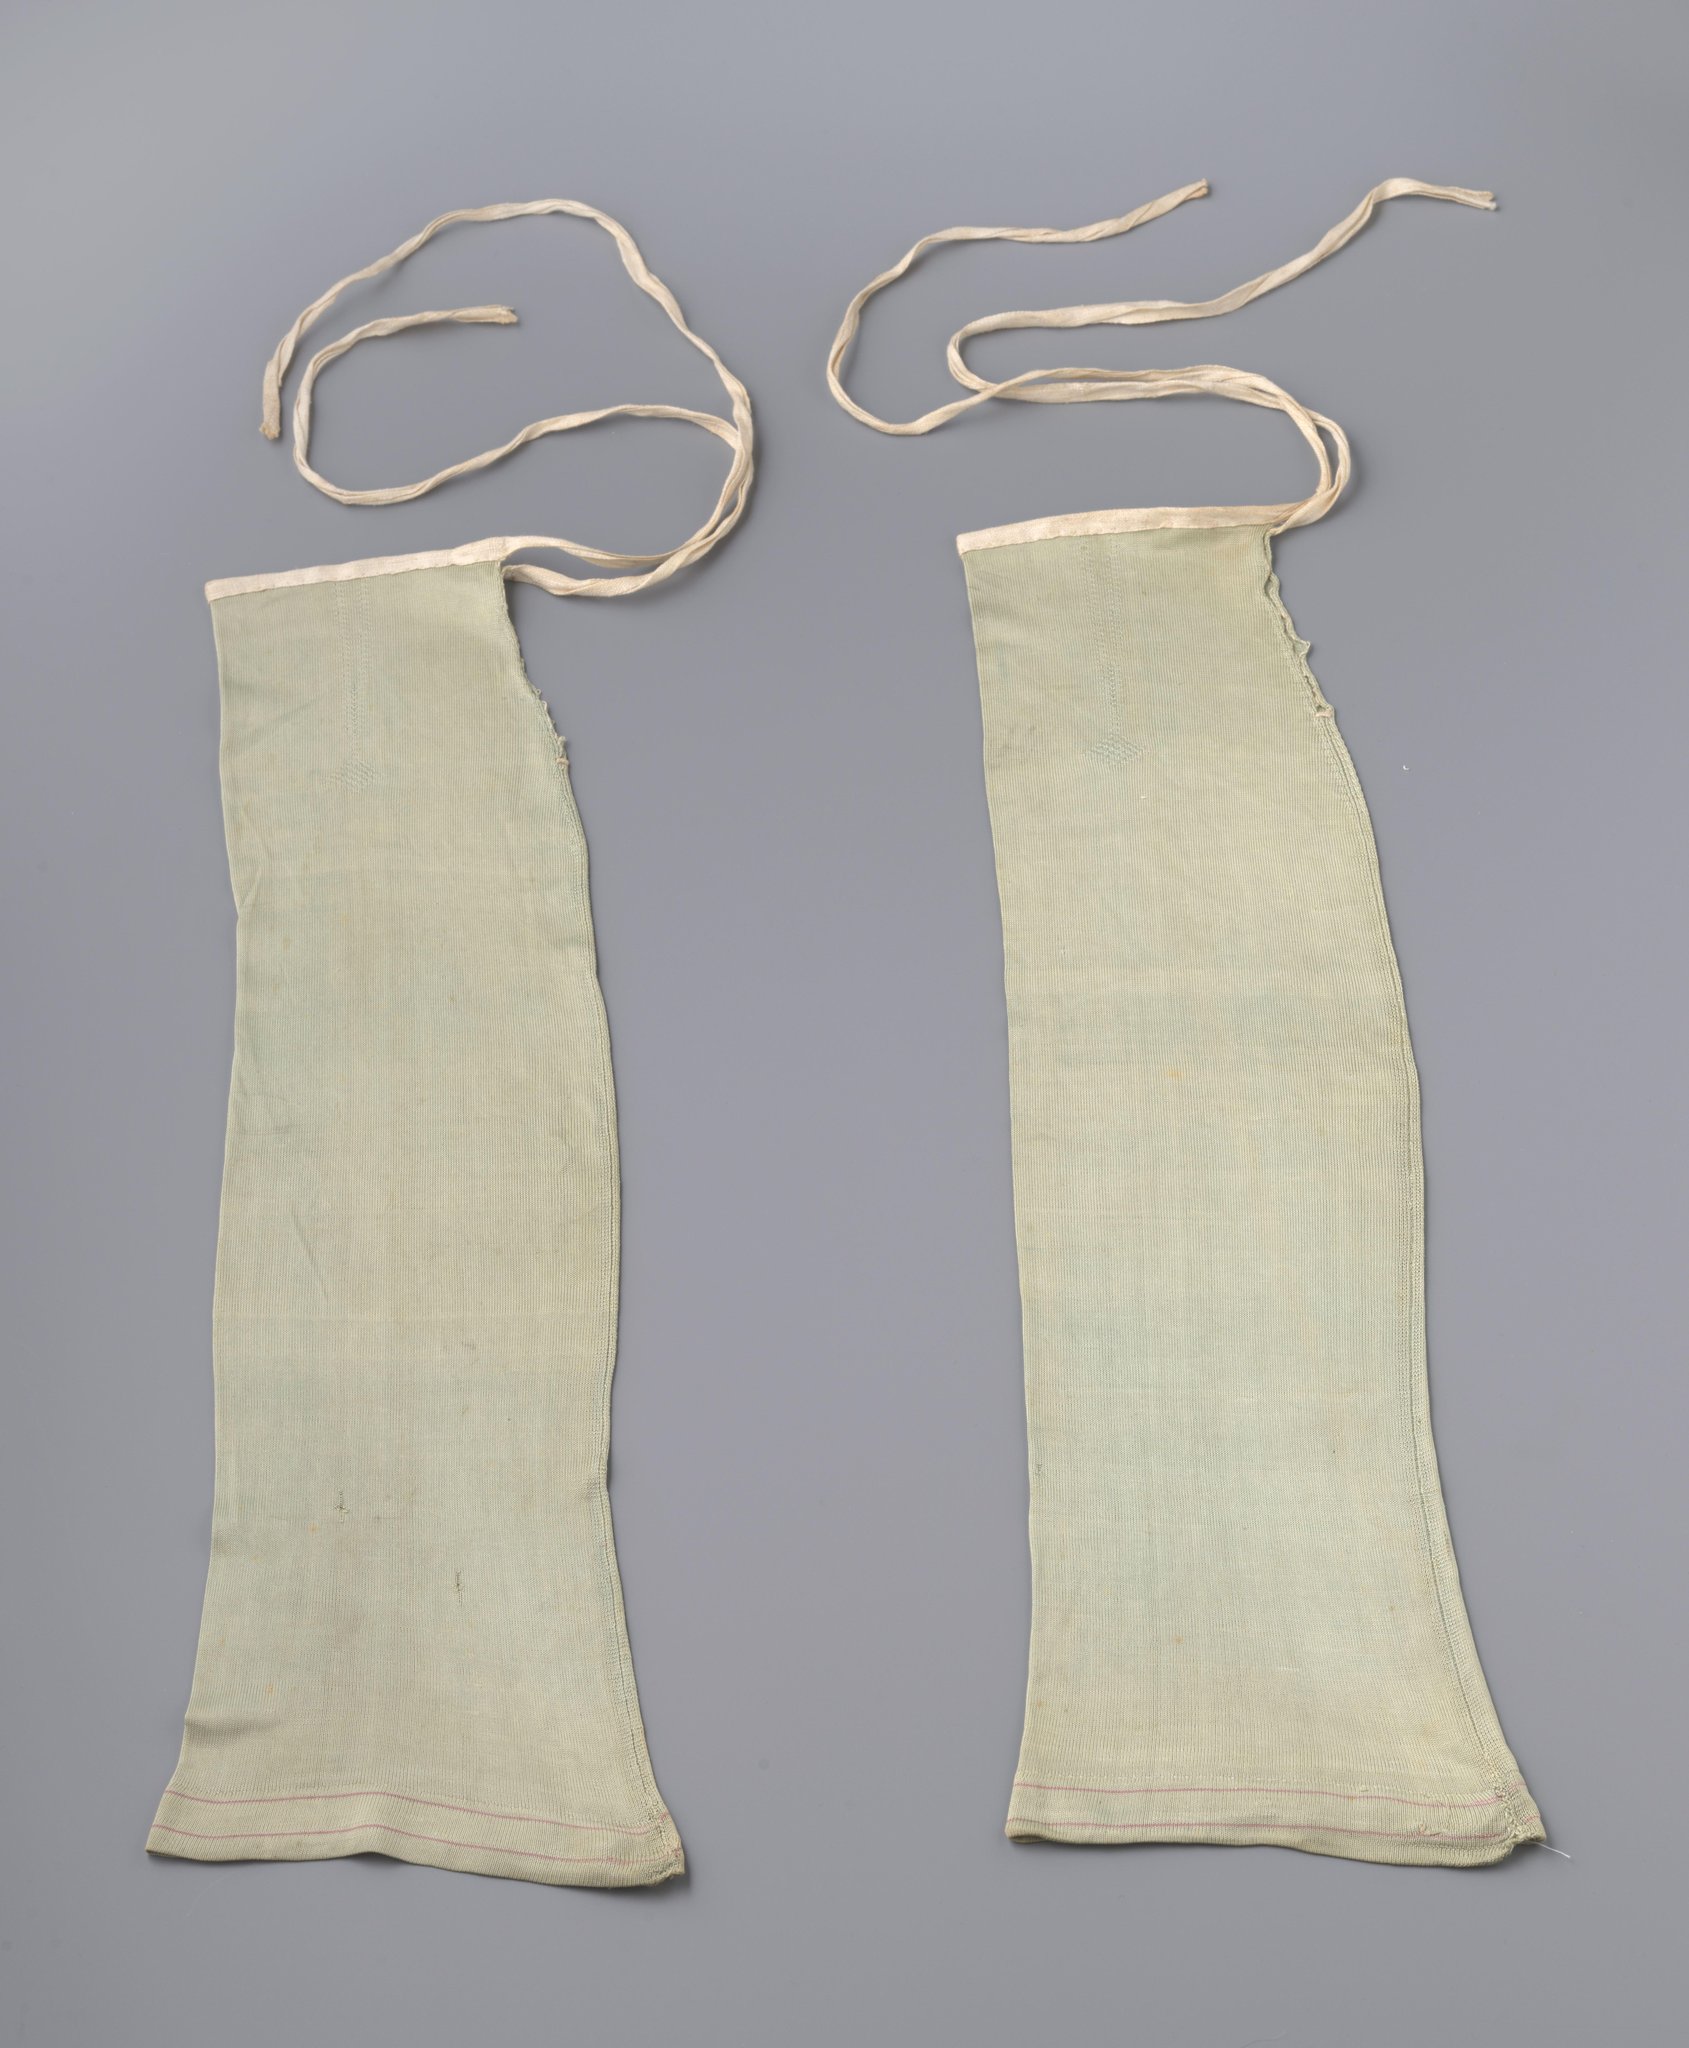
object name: spat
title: Slob(?)kous van turquoise zijden tricot, zonder voet, bij de klink lange ecrukleurige linnen linten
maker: Anonymous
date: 1700-1800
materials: linen, silk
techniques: knitting, weave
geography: netherlands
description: Slob(?)kous van turquoise zijden tricot met een diamantvomige decoratie op de klink. Zonder voet, split bij de hiel. Bij de klink lange ecrukleurige linnen linten. Langs de bovenrand twee fijne meegebreide paarse strepen.